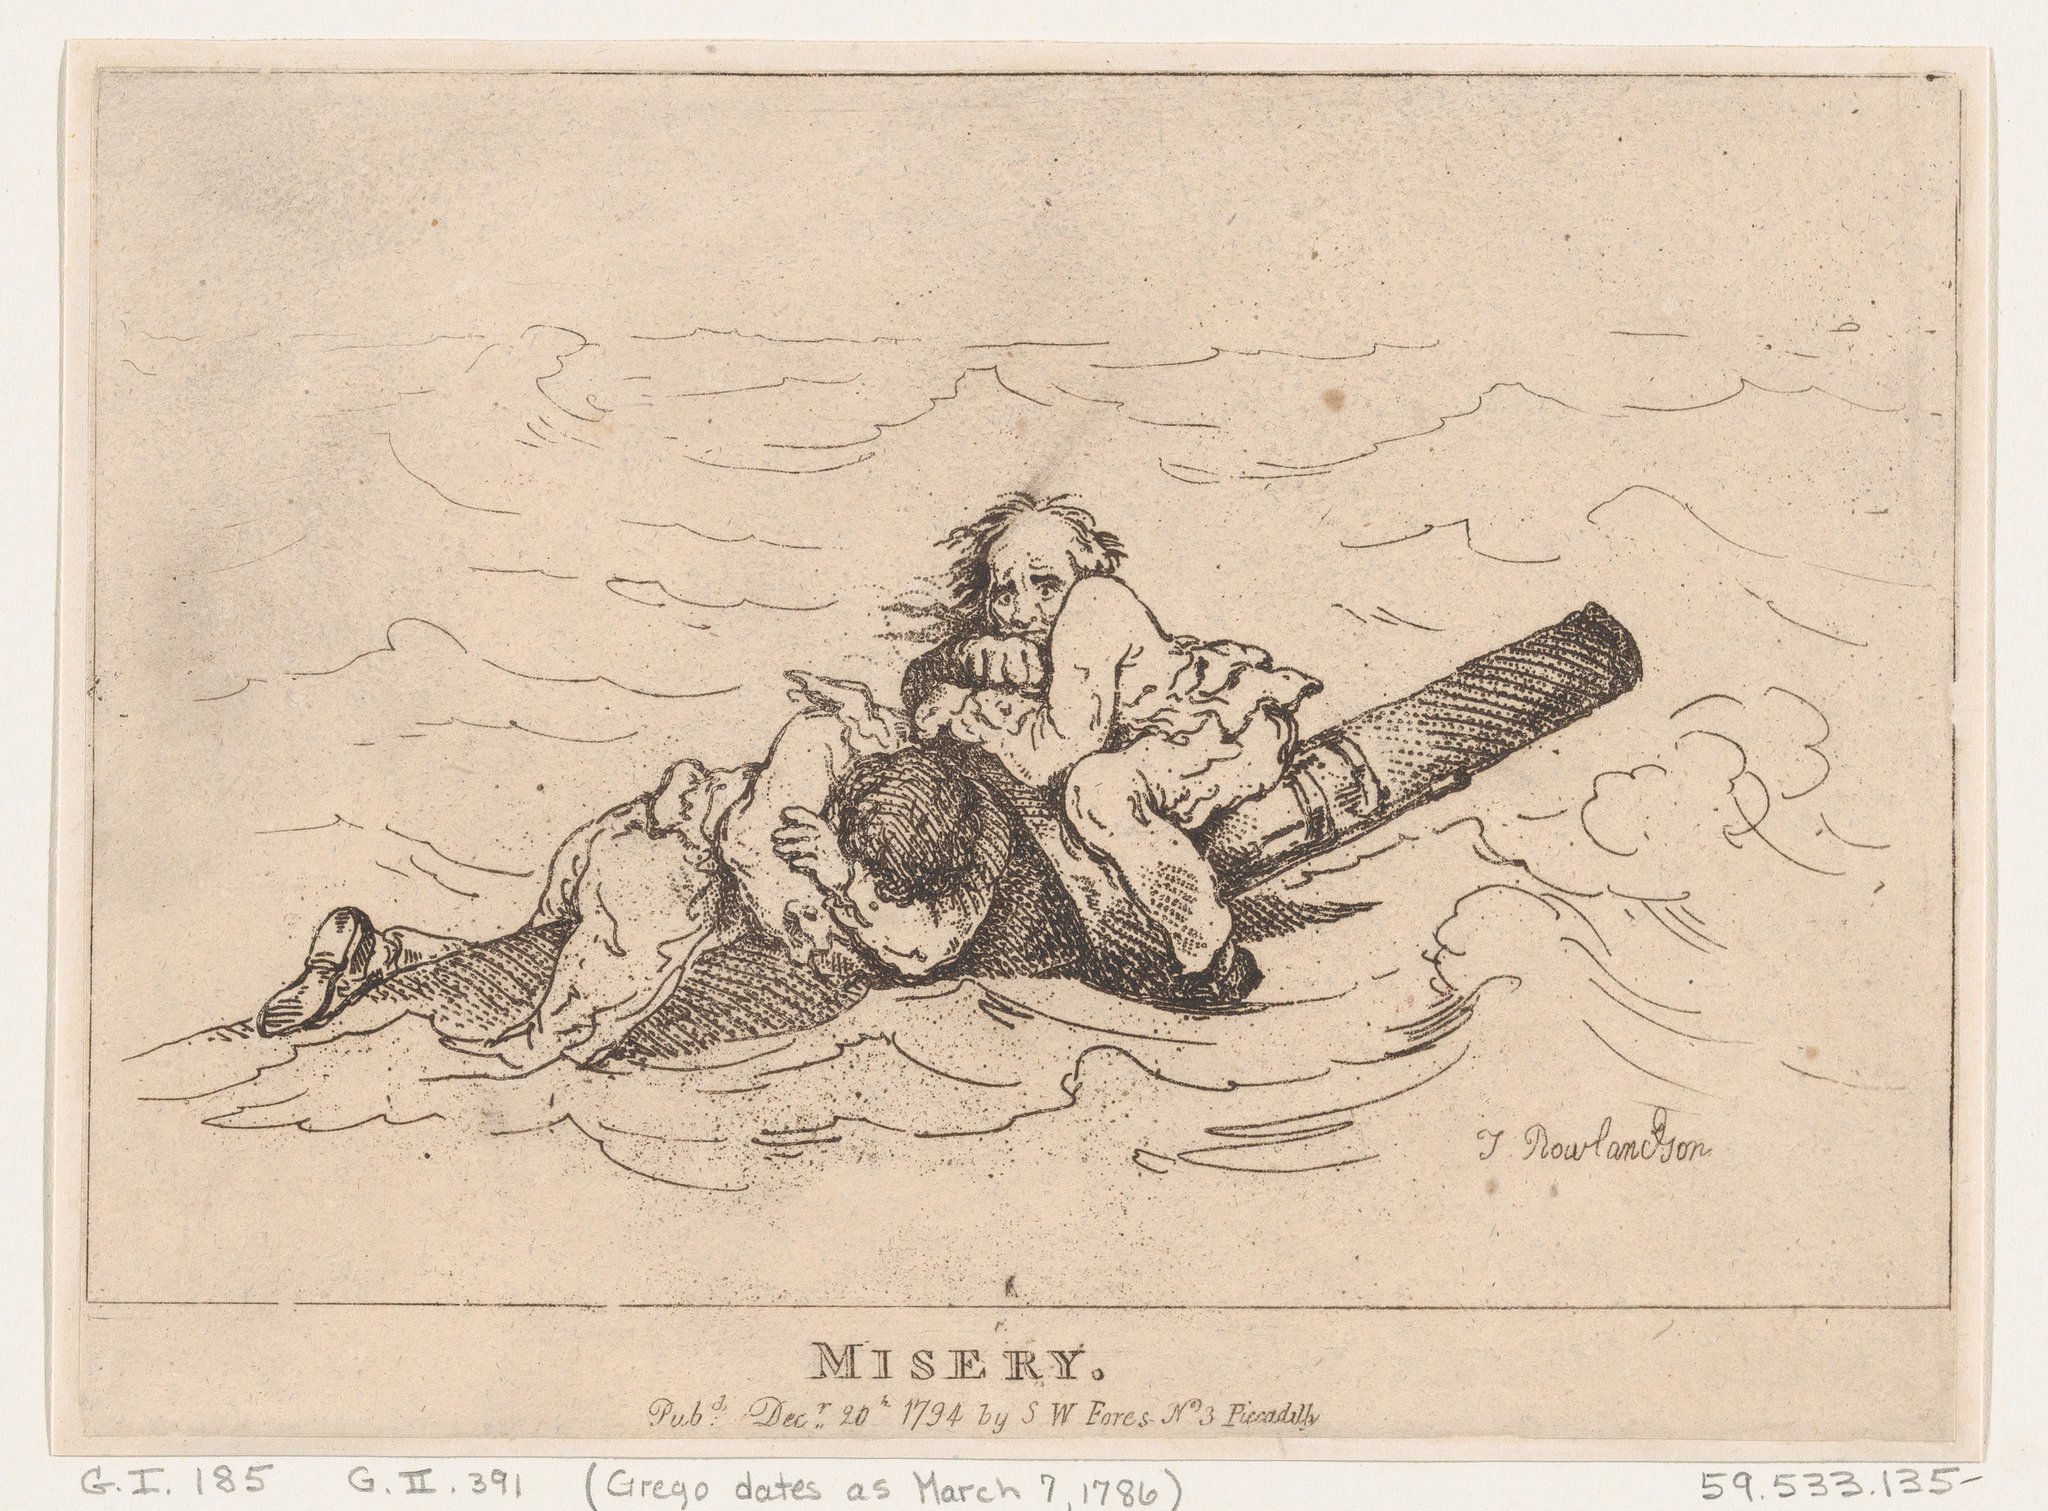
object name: print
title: Misery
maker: thomas rowlandson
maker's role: artist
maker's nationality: british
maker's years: 1757-1827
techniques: etching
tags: satire,fear,men